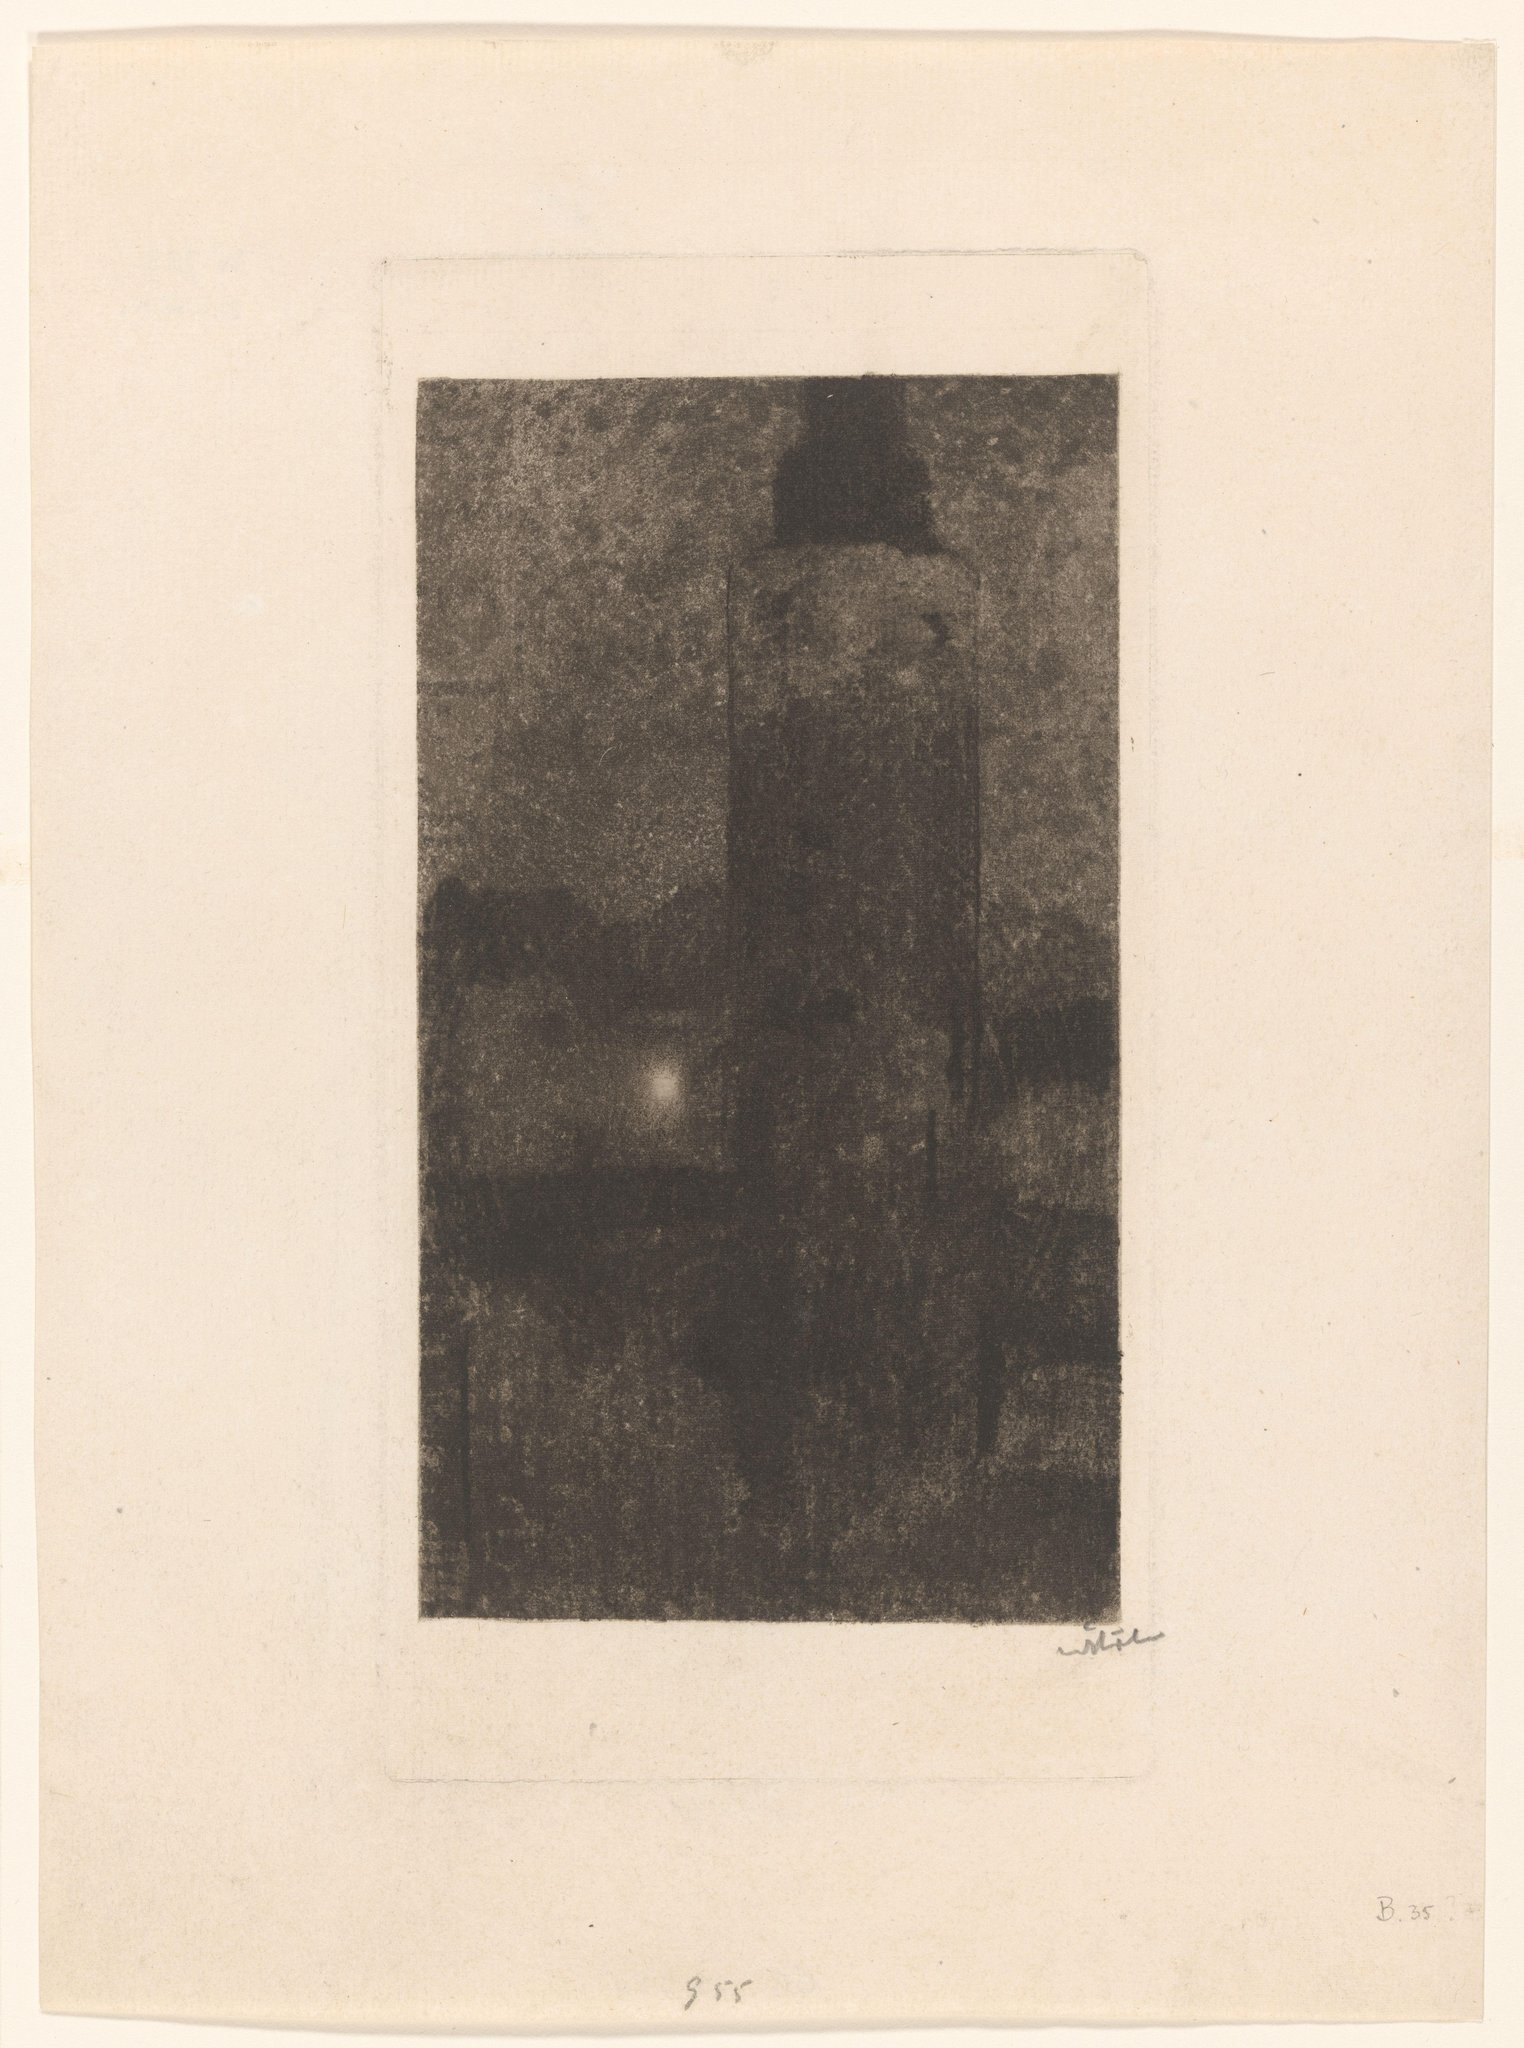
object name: print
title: Montelbaanstoren bij avond in Amsterdam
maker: willem witsen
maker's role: draughtsman, painter, print maker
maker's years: 1860-1923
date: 1887-1888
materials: paper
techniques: aquatint, intaglio, soft ground etching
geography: amsterdam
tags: tower, clock tower ~ monumental adornment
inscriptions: signature: ‘Witsen’